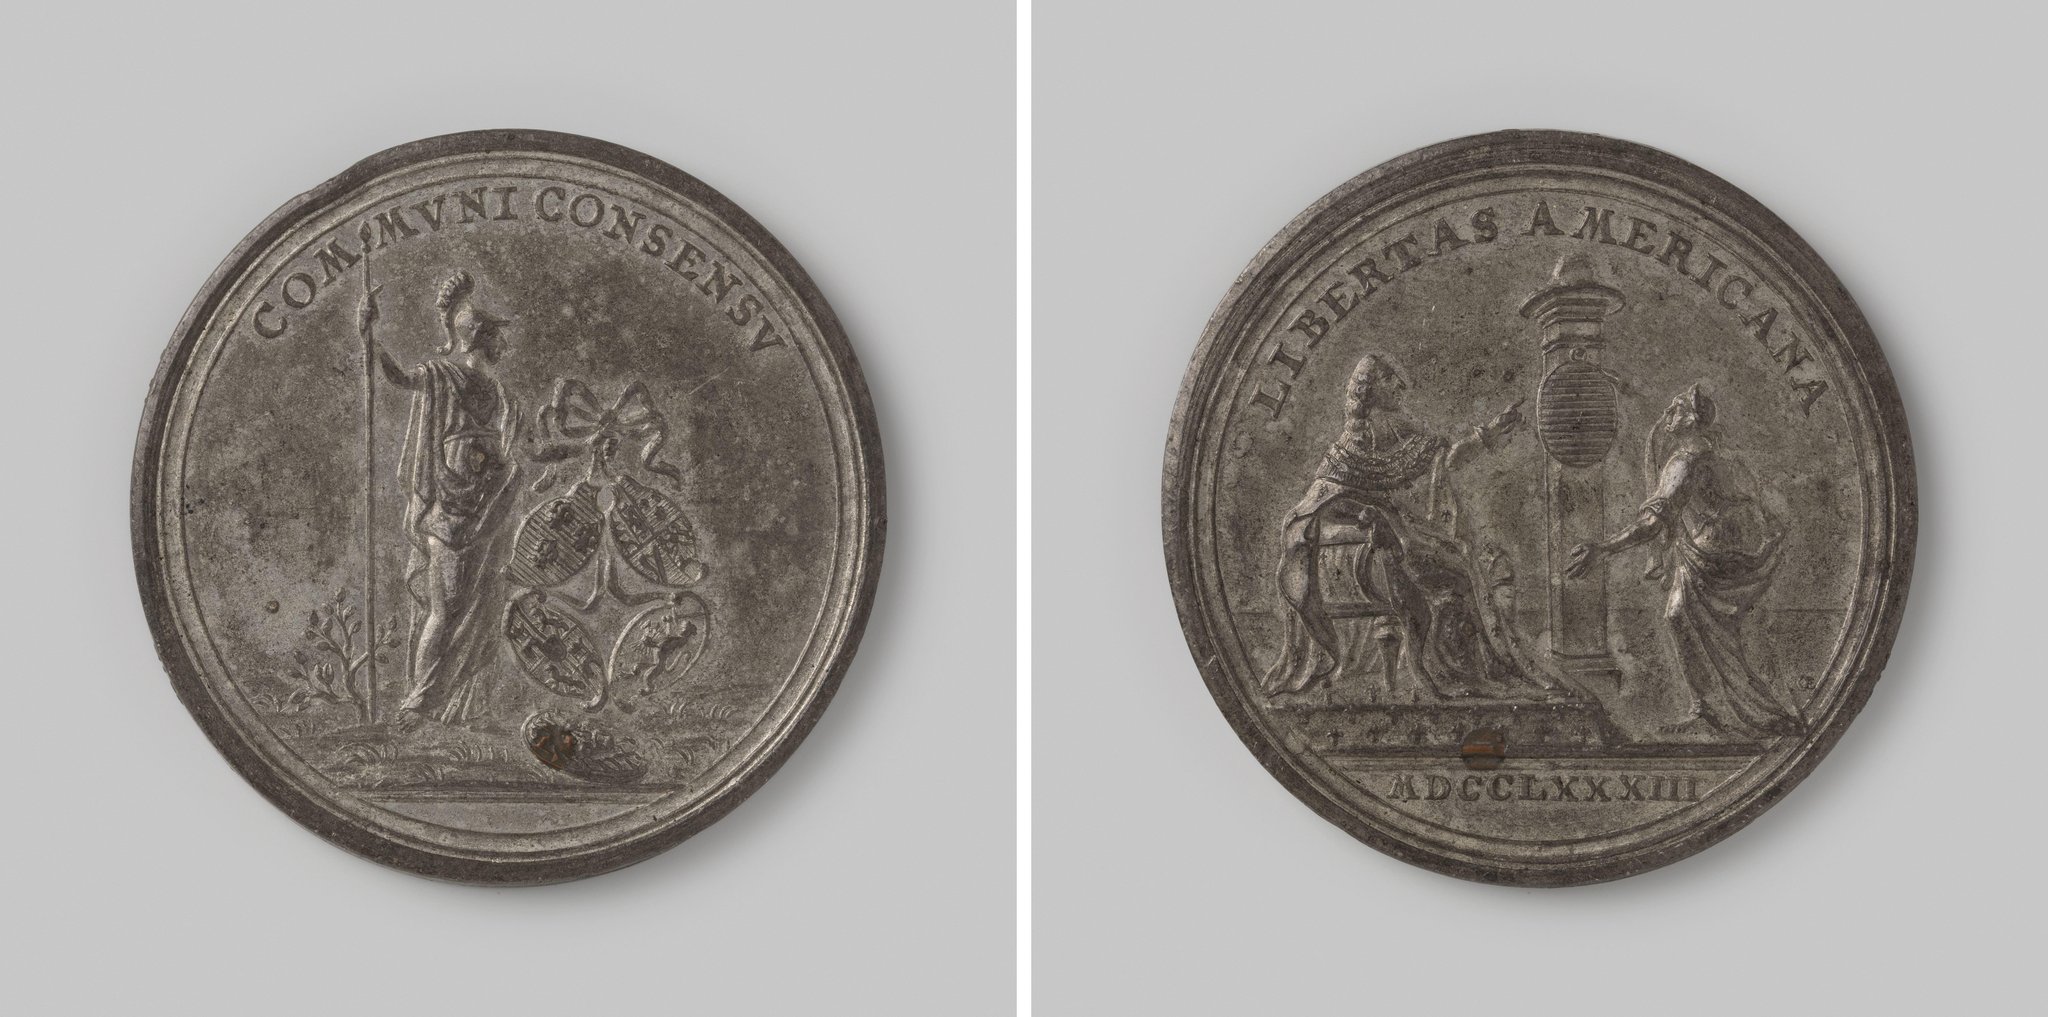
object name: history medal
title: Onafhankelijkheid van de Verenigde Staten van Amerika en het sluiten van de Vrede van Parijs met Engeland 1783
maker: jean léonard oexlin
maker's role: die cutter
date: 1783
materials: copper, tin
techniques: pressing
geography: regensburg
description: Tinnen penning met kleine koperen plug, op de voorzijde Minerva met piek en samengebonden linten met de wapenschilden van Frankrijk, Engeland, Spanje en Nederland, met omschrift, op de keerzijde de Franse koning die wijst naar een ovaal schild met dertien banen dat een jonge vrouw ophangt aan een zuil met vrijheidshoed, met omschrift en afsnedetekst.